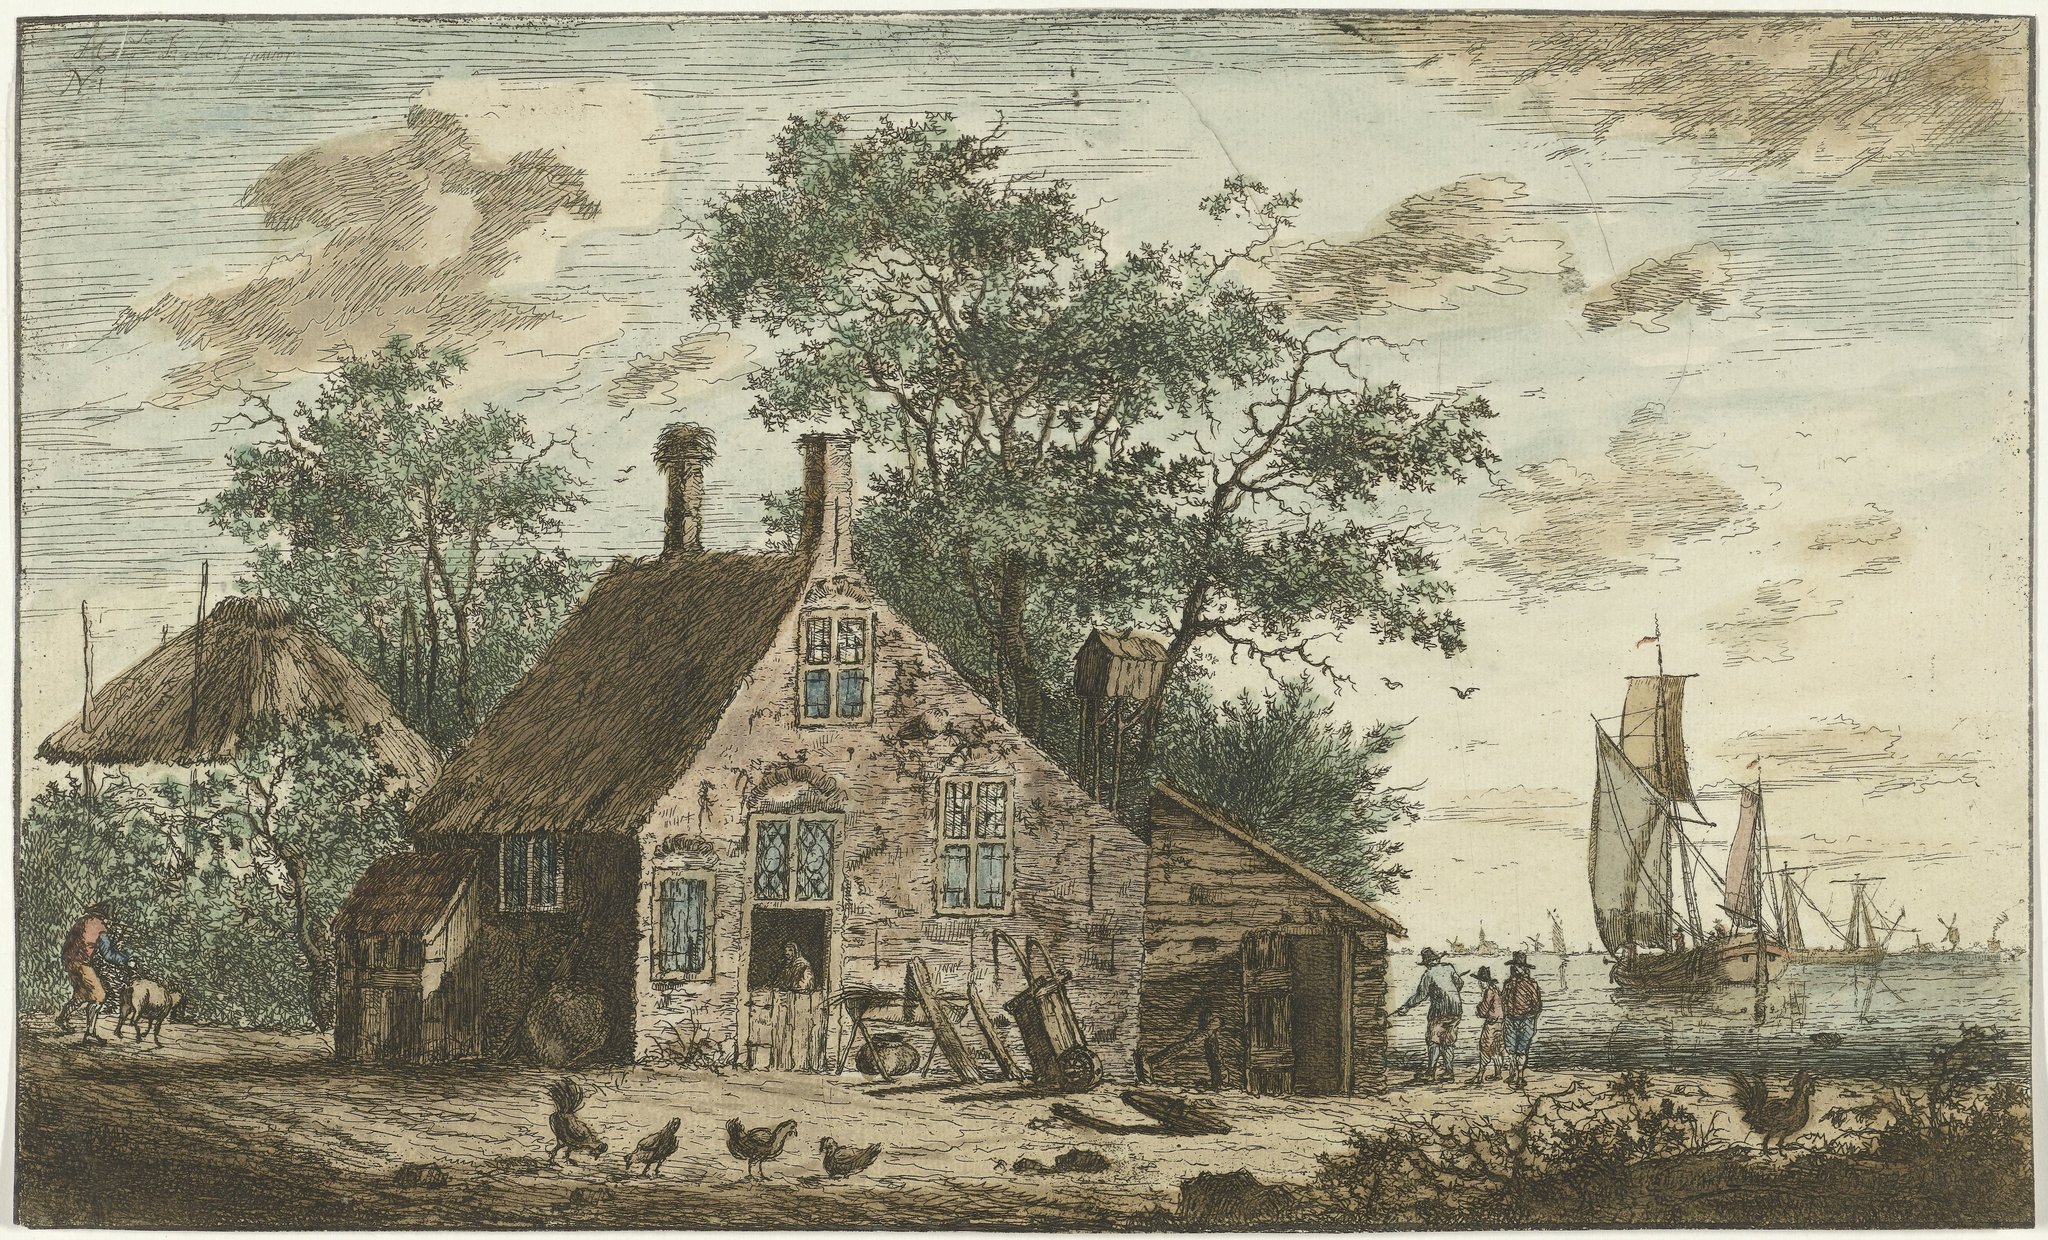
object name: print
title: Boerderij aan een rivier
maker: hendrik kobell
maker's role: draughtsman, painter, print maker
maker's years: 1751-1779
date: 1768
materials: paper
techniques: etching, hand coloring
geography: rotterdam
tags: nesting-box, sailing-ship, sailing-boat, hay-stack, windmill, farm or solitary house in landscape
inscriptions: collector's mark: Lugt 2228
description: Boerderij bij een rivier met op de voorgrond enkele kippen en een haan. Tegen de voorkant van de boerderij staan een kruiwagen en een kribbe, en in de deuropening staat een figuur. Links loopt een man met een geit en rechts staan drie figuren bij een kleine schuur met duiventil. Op het water zijn enkele zeilschepen te zien en op de achtergrond zijn de contouren van een kerk en molens zichtbaar.